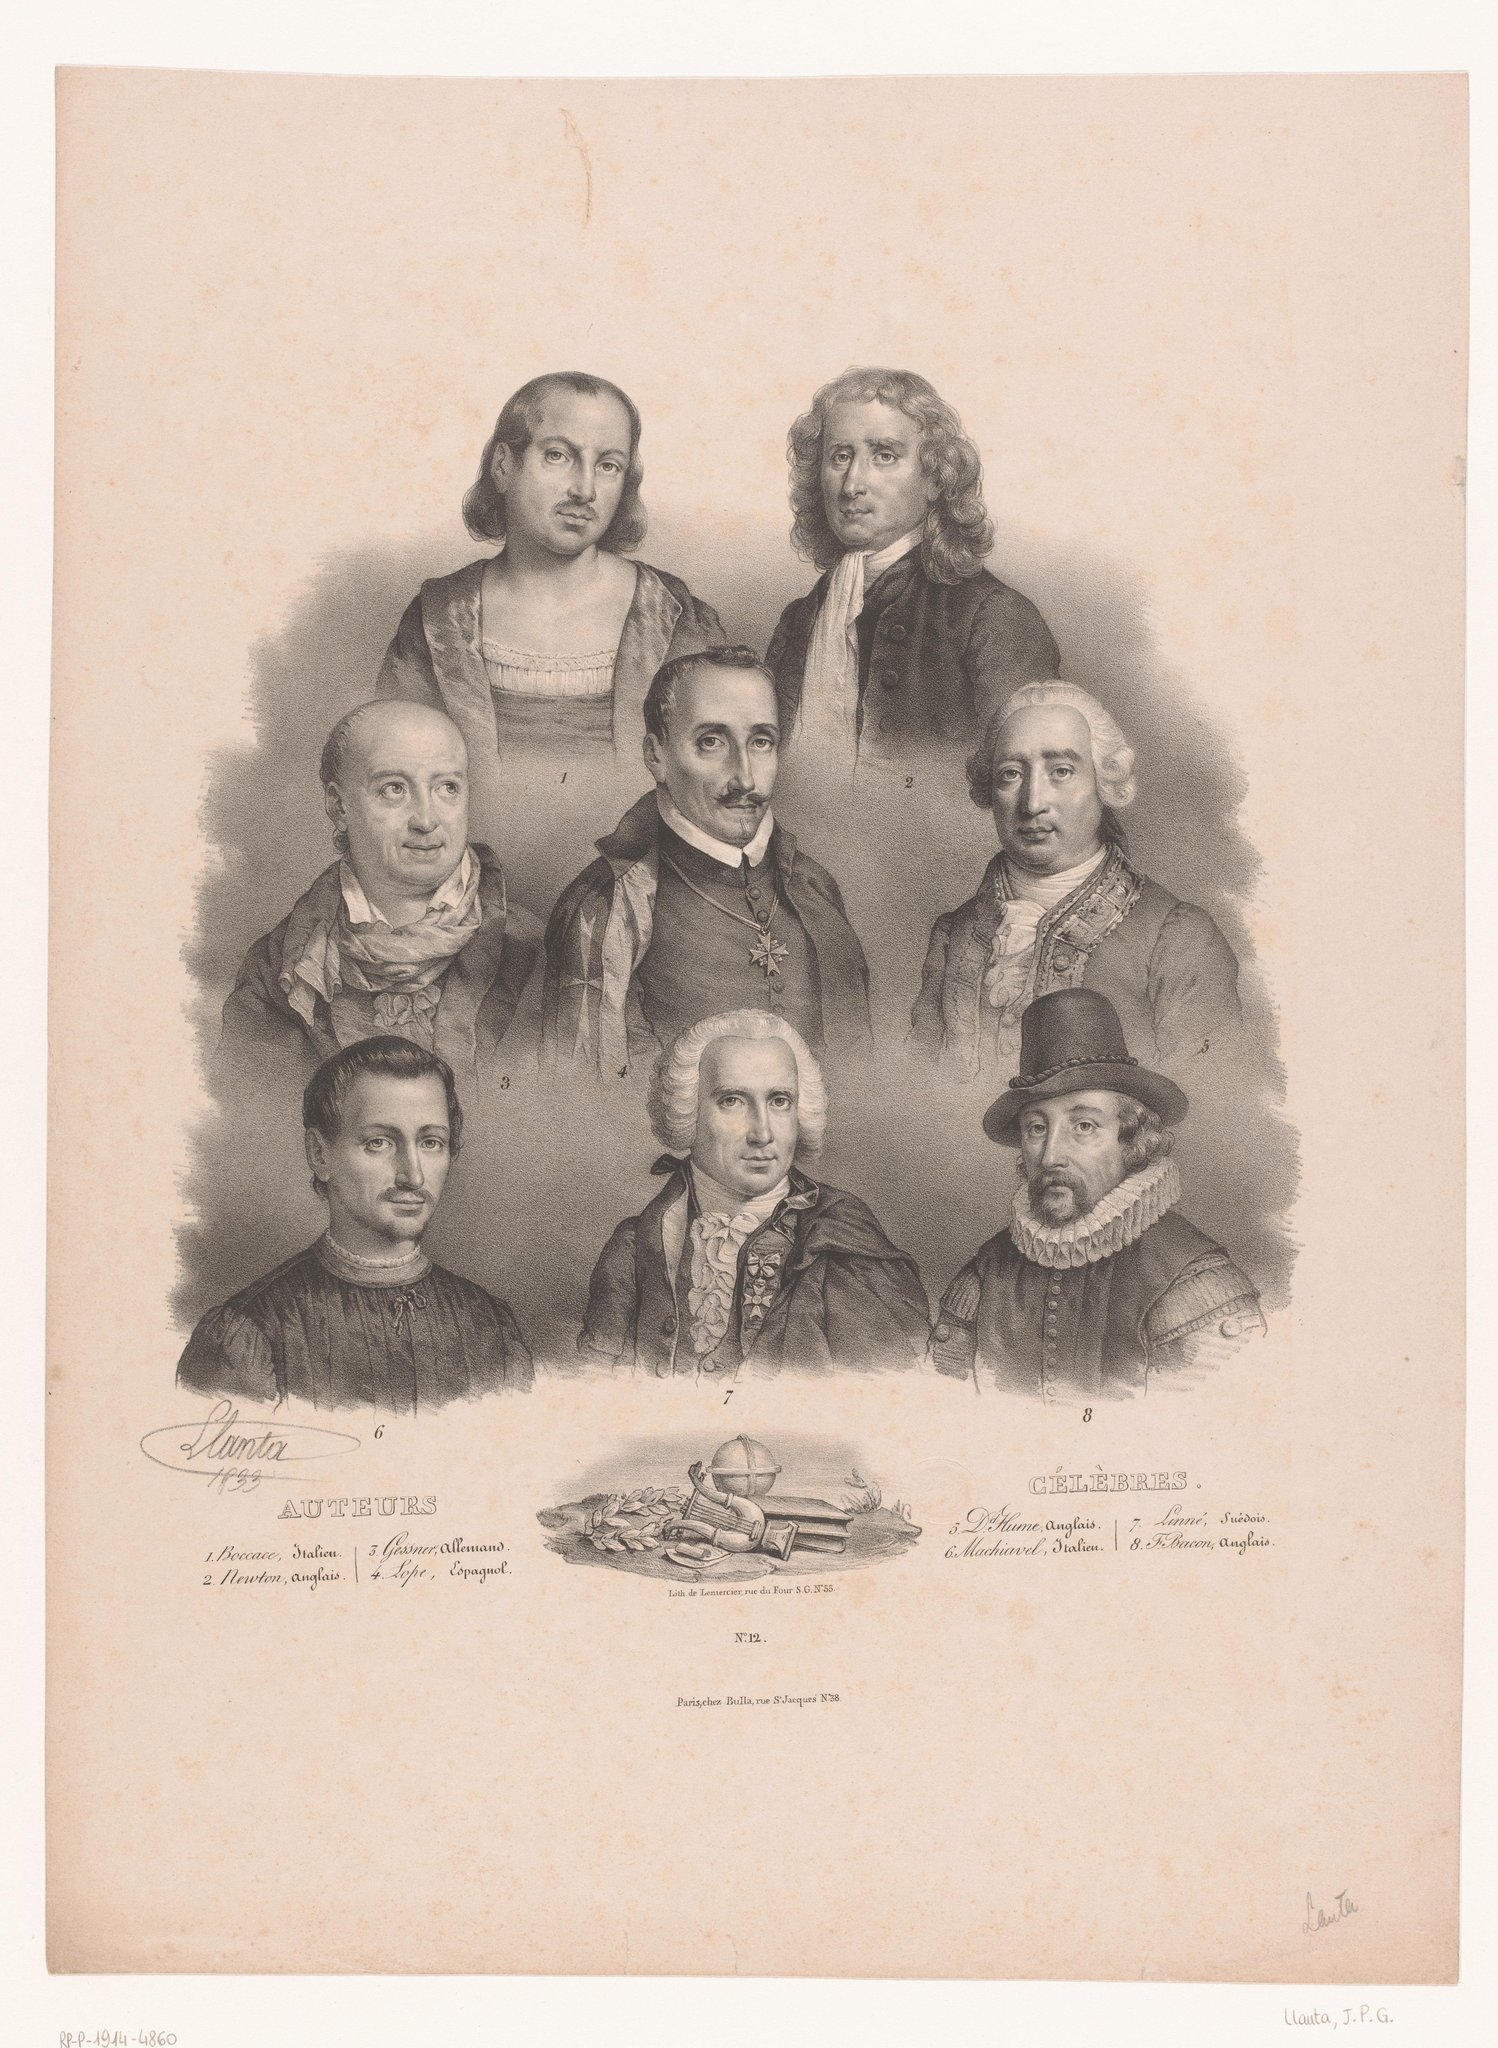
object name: print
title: Auteurs célèbres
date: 1833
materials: paper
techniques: lithograph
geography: paris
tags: painter, print maker, salomon gessner, carl linnaeus, giovanni boccaccio, david hume, london, physicist, historical persons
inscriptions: check stamp: Lugt 4088, collector's mark: Lugt 2228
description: Portretten van Europese schrijvers met genummerde lijst: 1. Giovanni Boccaccio, 2. Isaac Newton, 3. Salomon Gessner, 4. Félix Lope de Vega Carpio, 5. David Hume, 6. Niccolò Machiavelli, 7. Carl Linnaeus, 8. Francis Bacon.